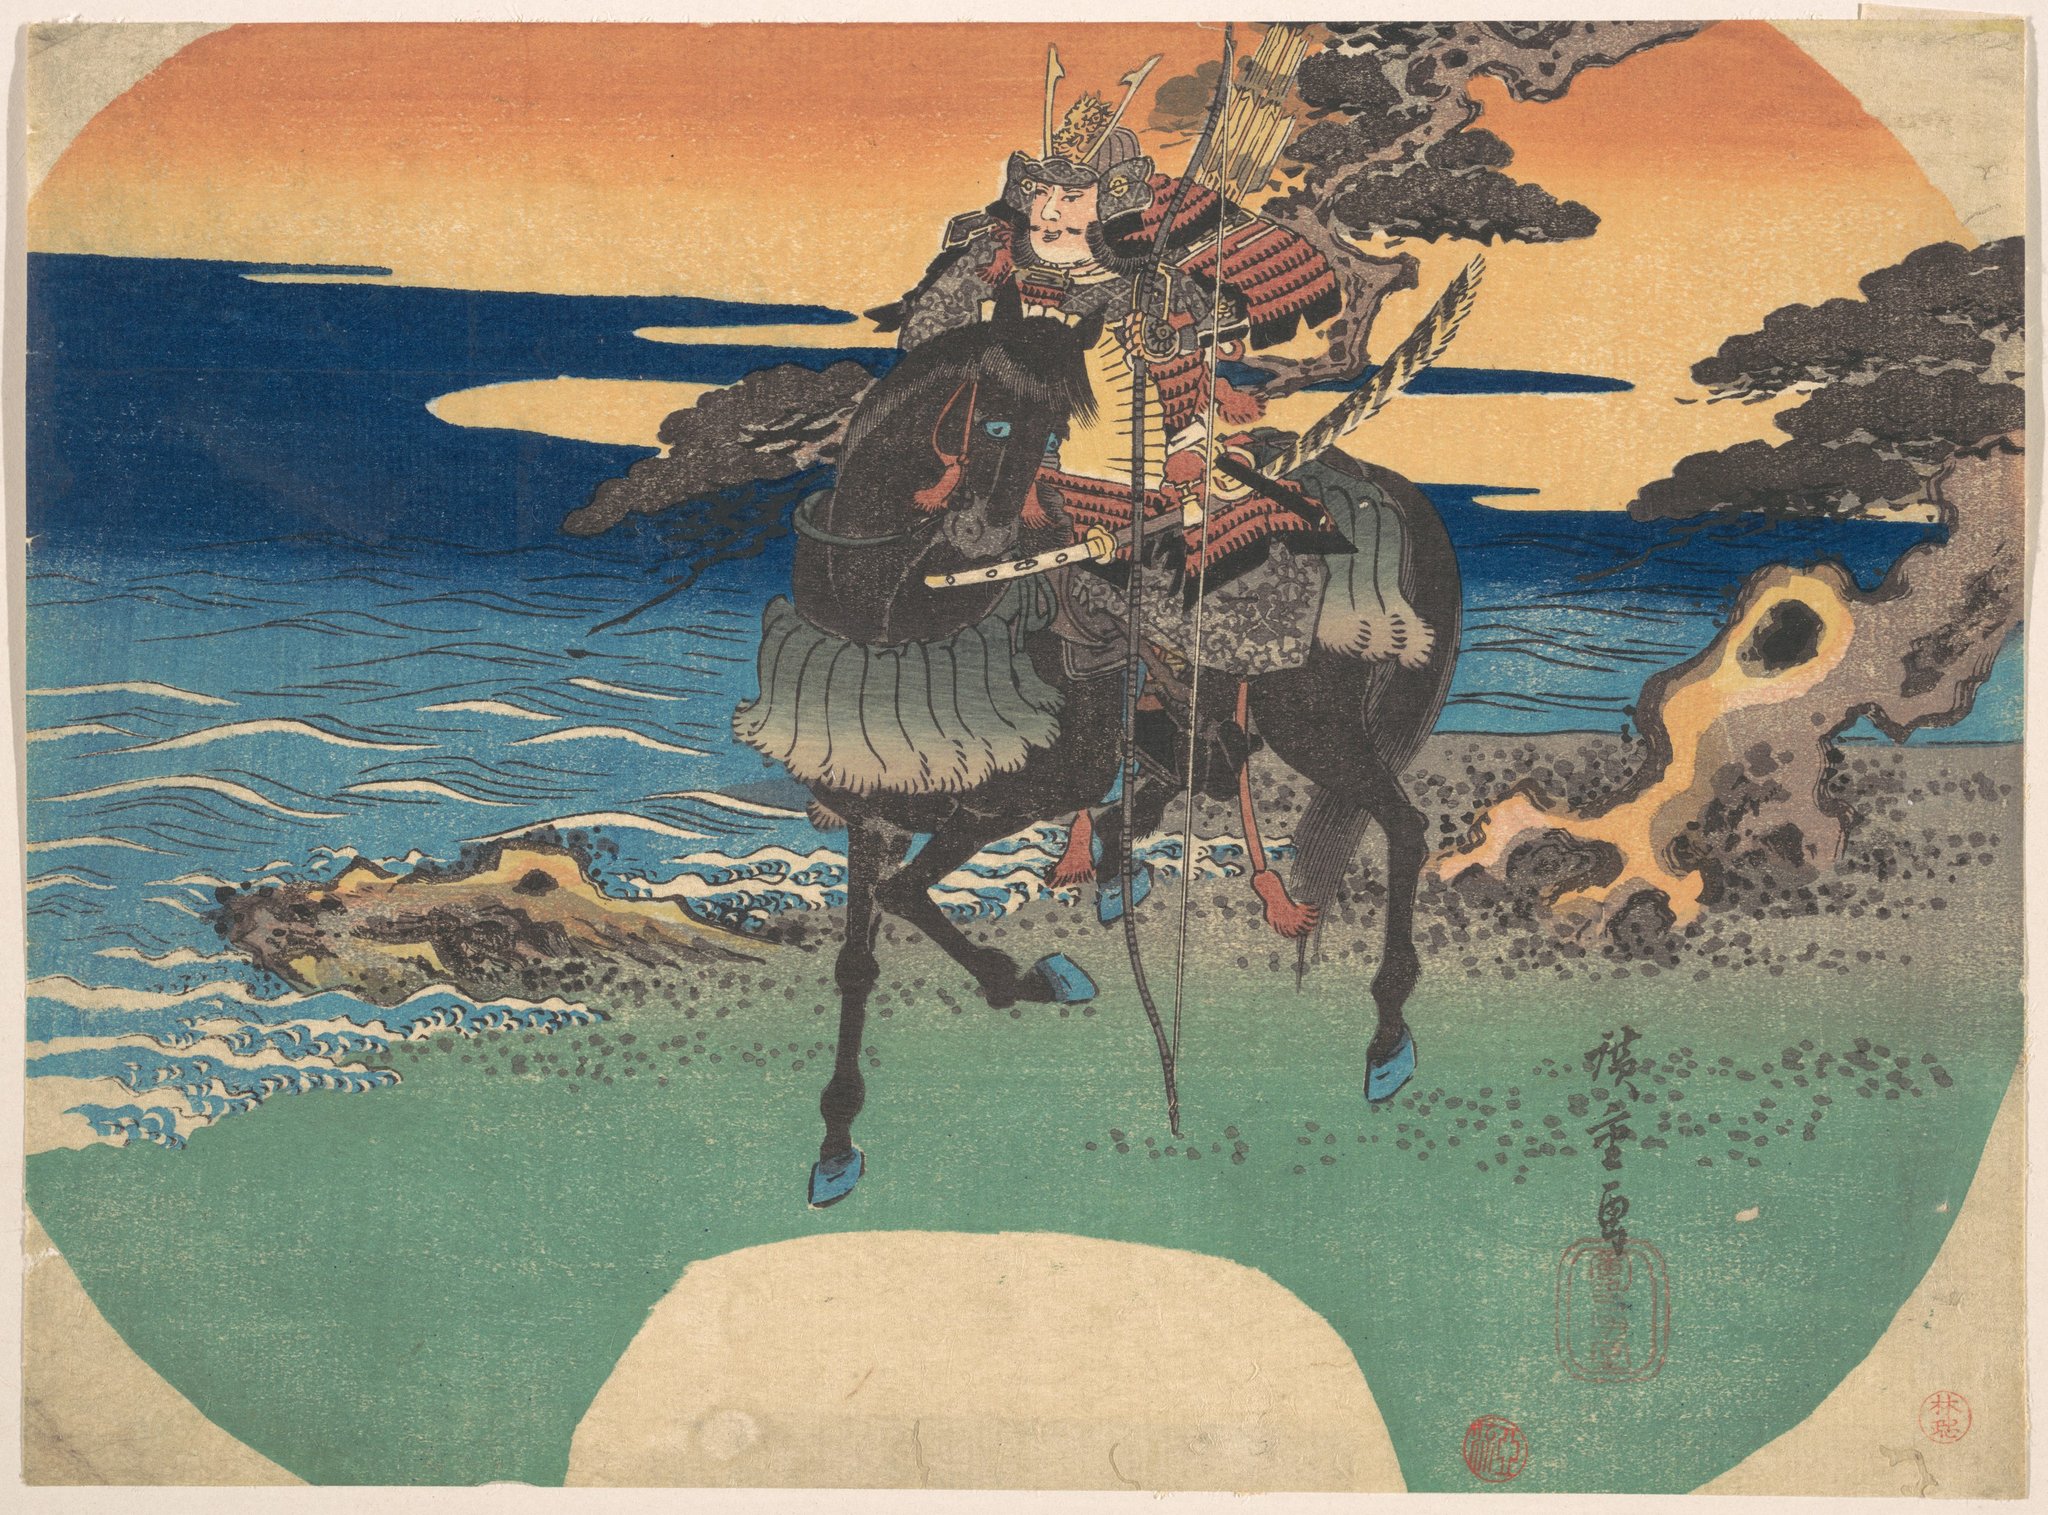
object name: woodblock print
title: Warrior Riding Black Horse along the Sea Shore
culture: japanese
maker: utagawa hiroshige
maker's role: artist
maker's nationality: japanese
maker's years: 1797-1858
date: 1835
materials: ink, paper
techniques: woodblock print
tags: bow and arrow,swords,men,horses,warriors